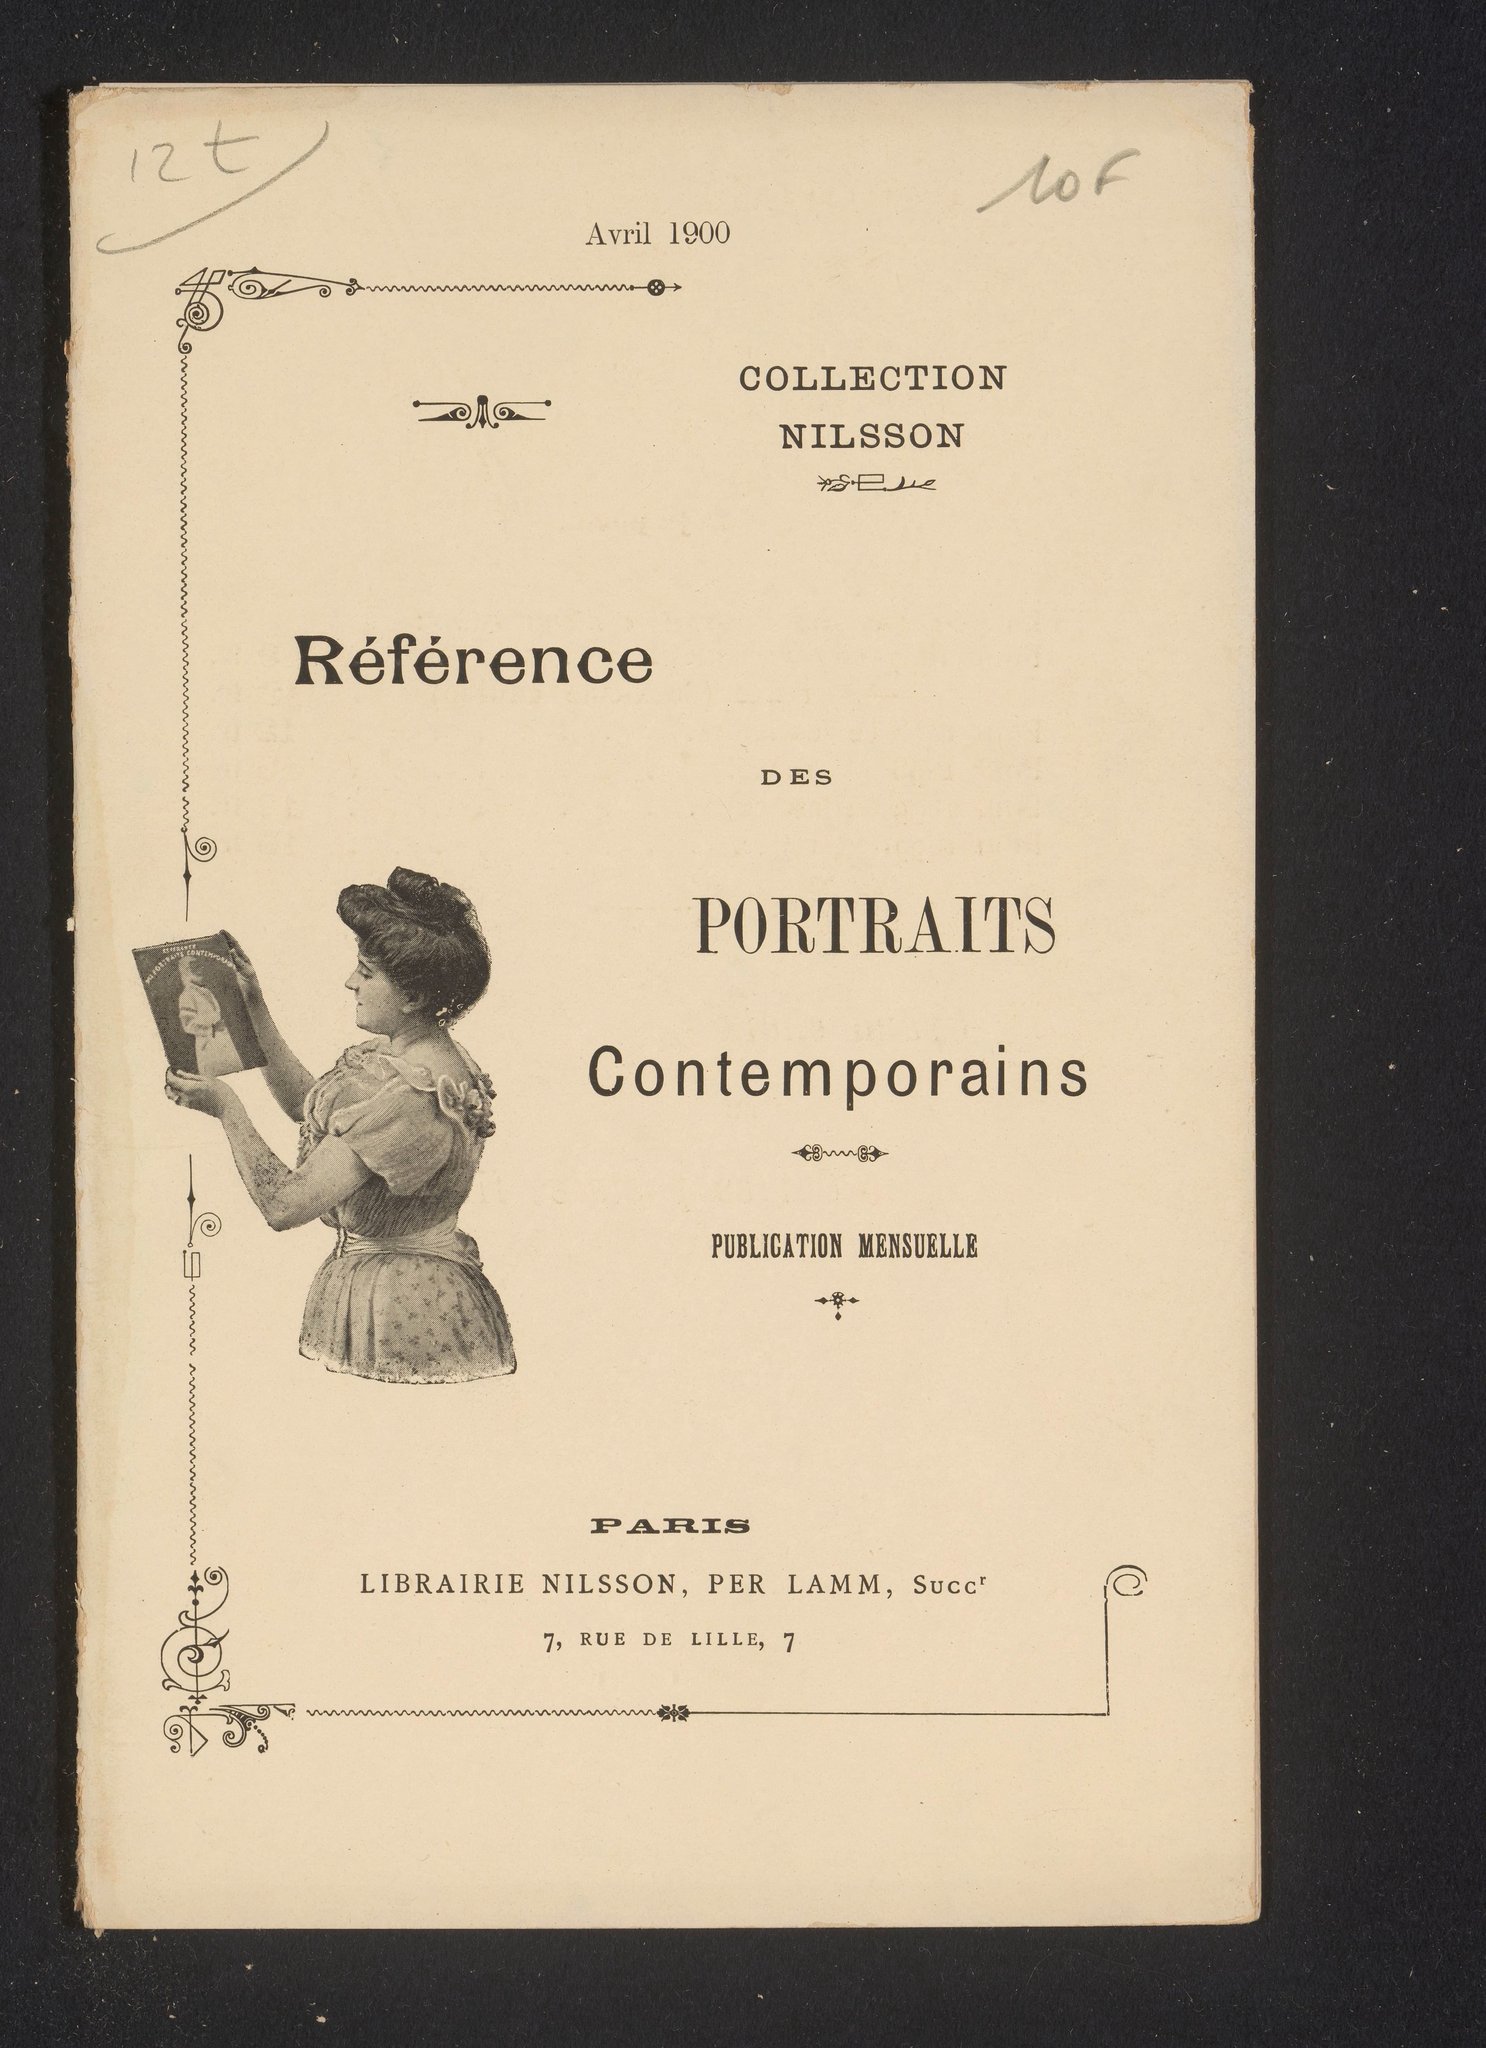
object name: magazine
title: Référence des portraits contemporains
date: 1900-1904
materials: paper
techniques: photograph, printing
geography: paris